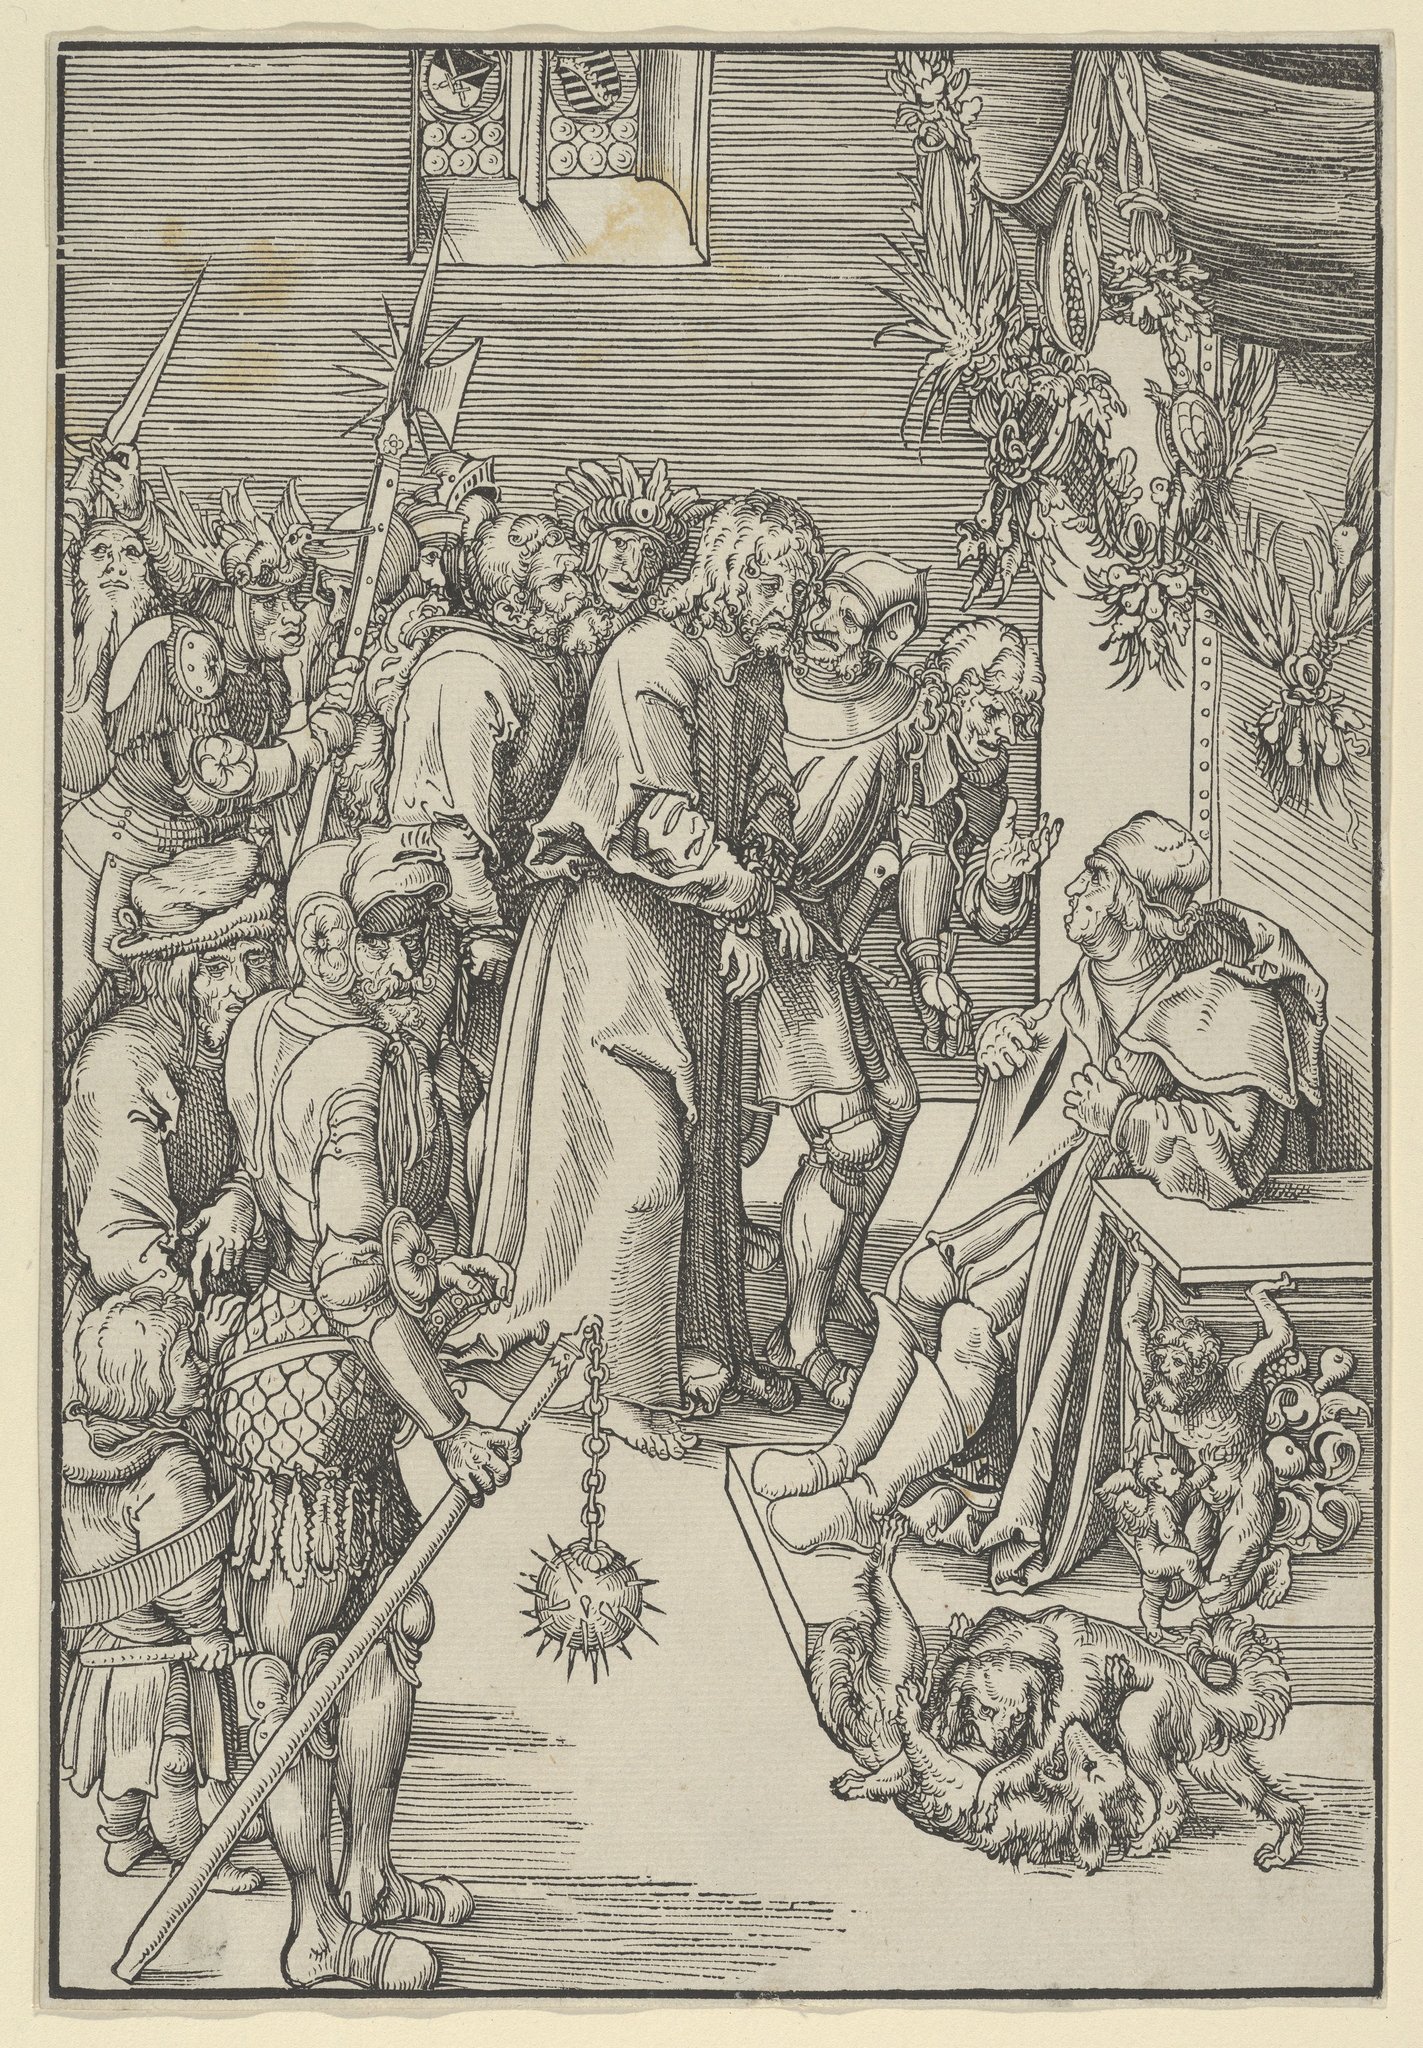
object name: print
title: Christ Before Annas, from the Passion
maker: lucas cranach the elder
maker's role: artist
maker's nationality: german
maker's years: 1472-1553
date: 1472-1553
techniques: woodcut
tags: men,christ